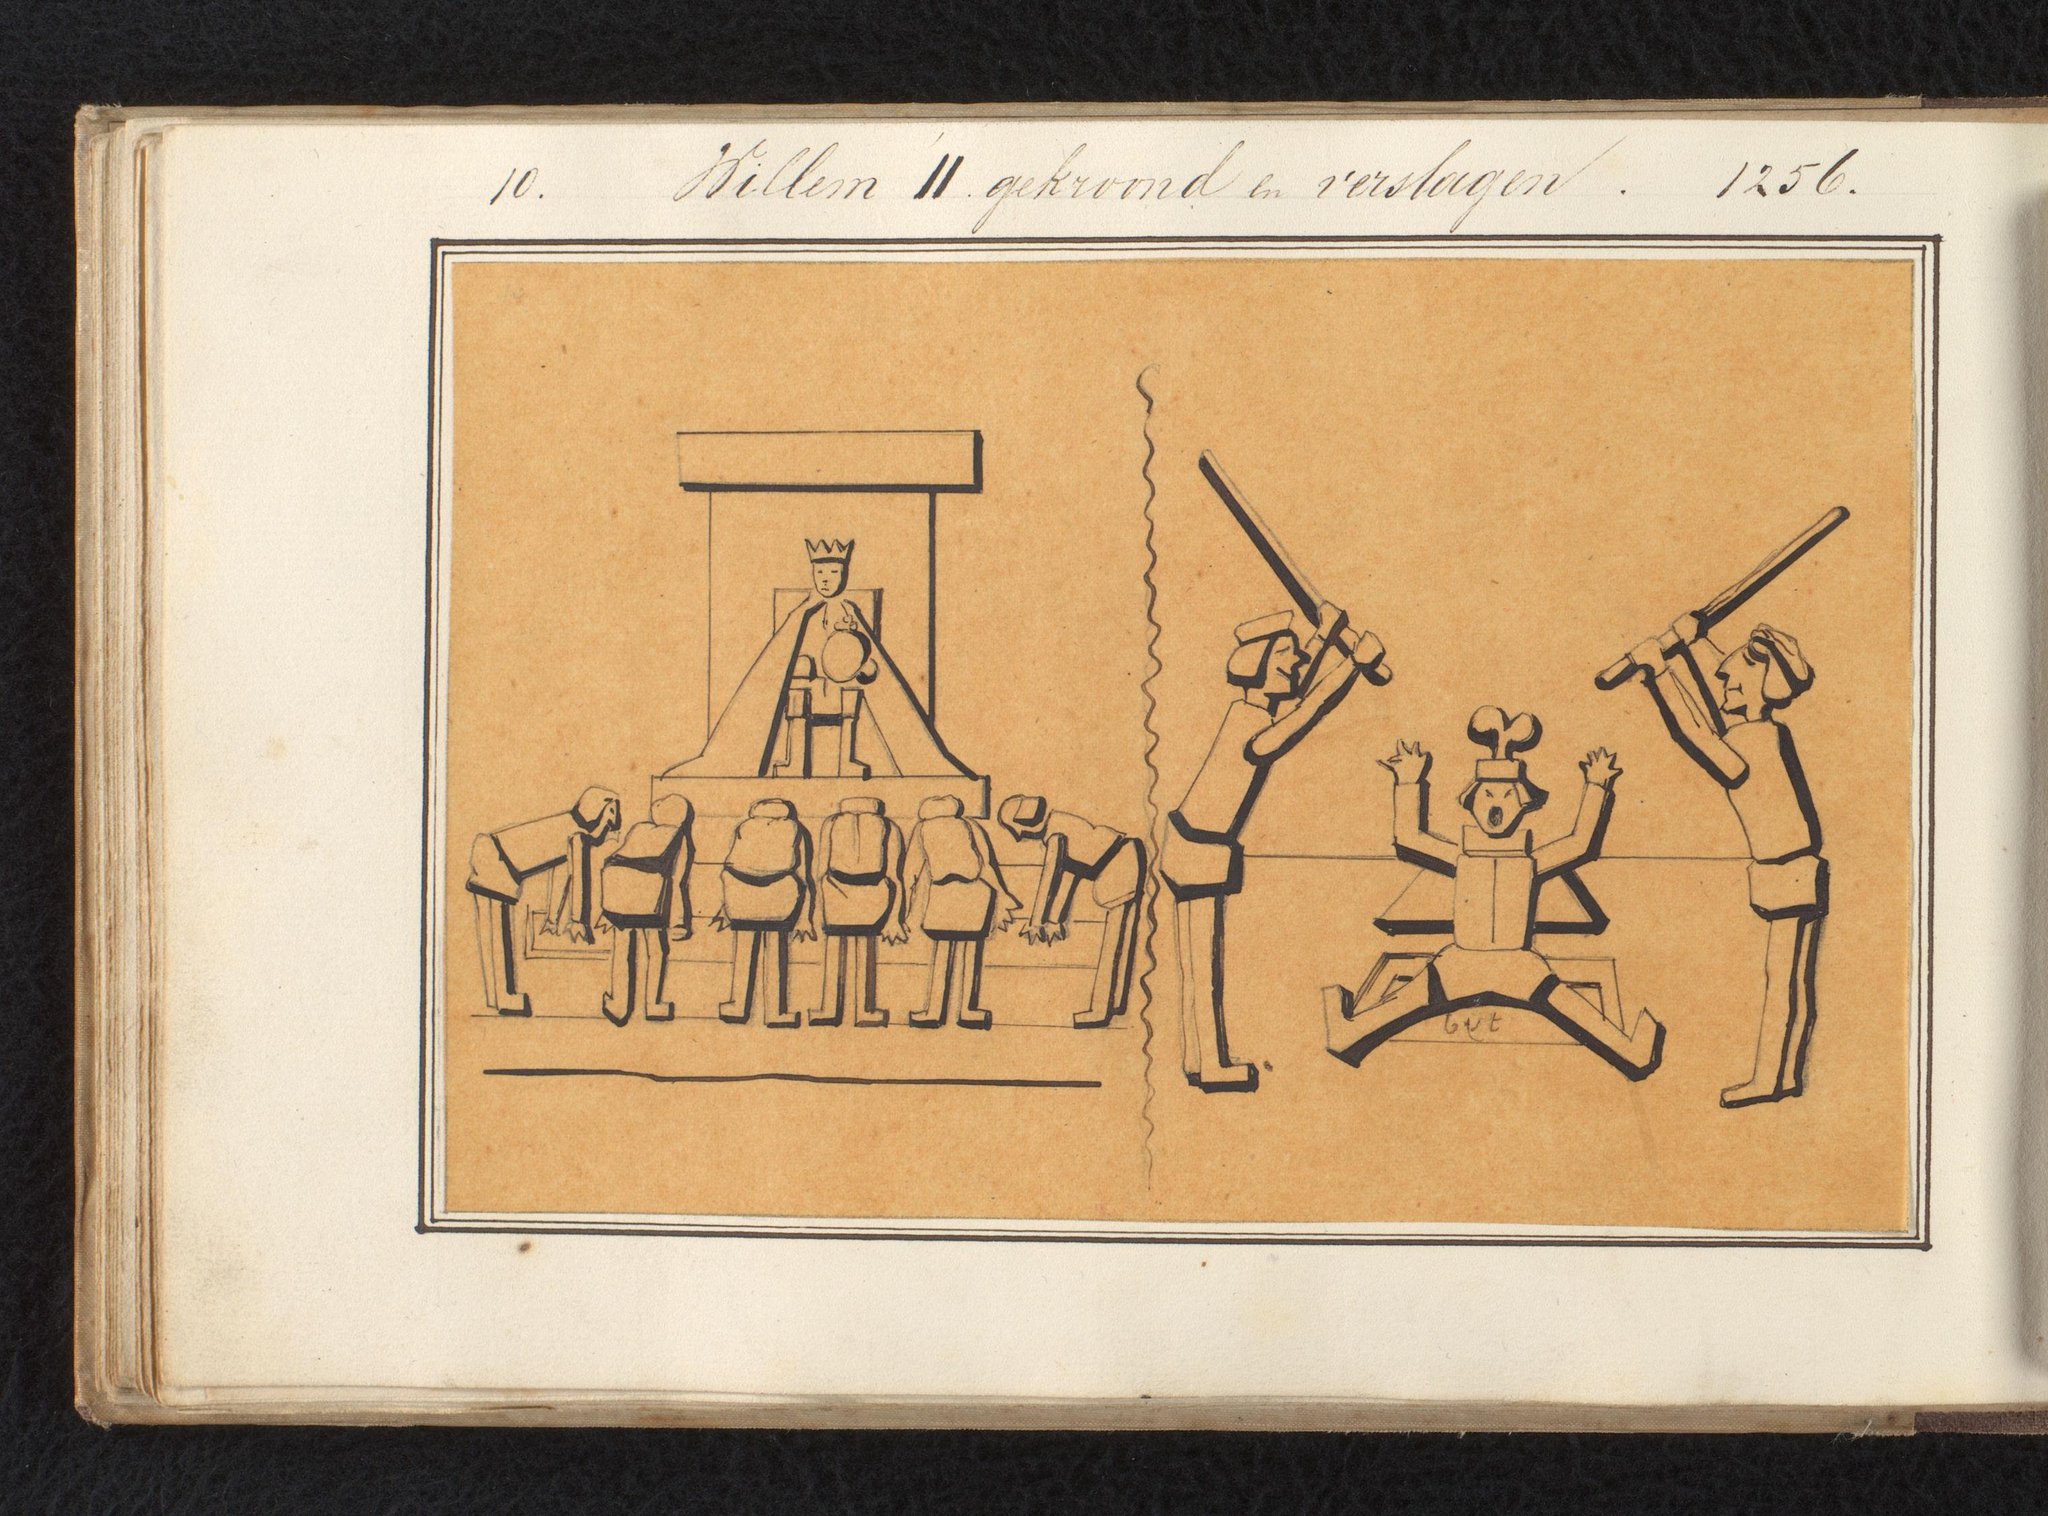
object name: drawing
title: Kroning en dood van Willem II, graaf van Holland, 1256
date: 1853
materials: ink, pencil, paper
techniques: pen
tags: earl, coronation of a ruler, murder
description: Ontwerp voor: Lennep, Jacob van. Tafereelen uit de geschiedenis des vaderlands, tot nut van groot en klein. Amsterdam: M.H. Binger en Zonen, 1854.